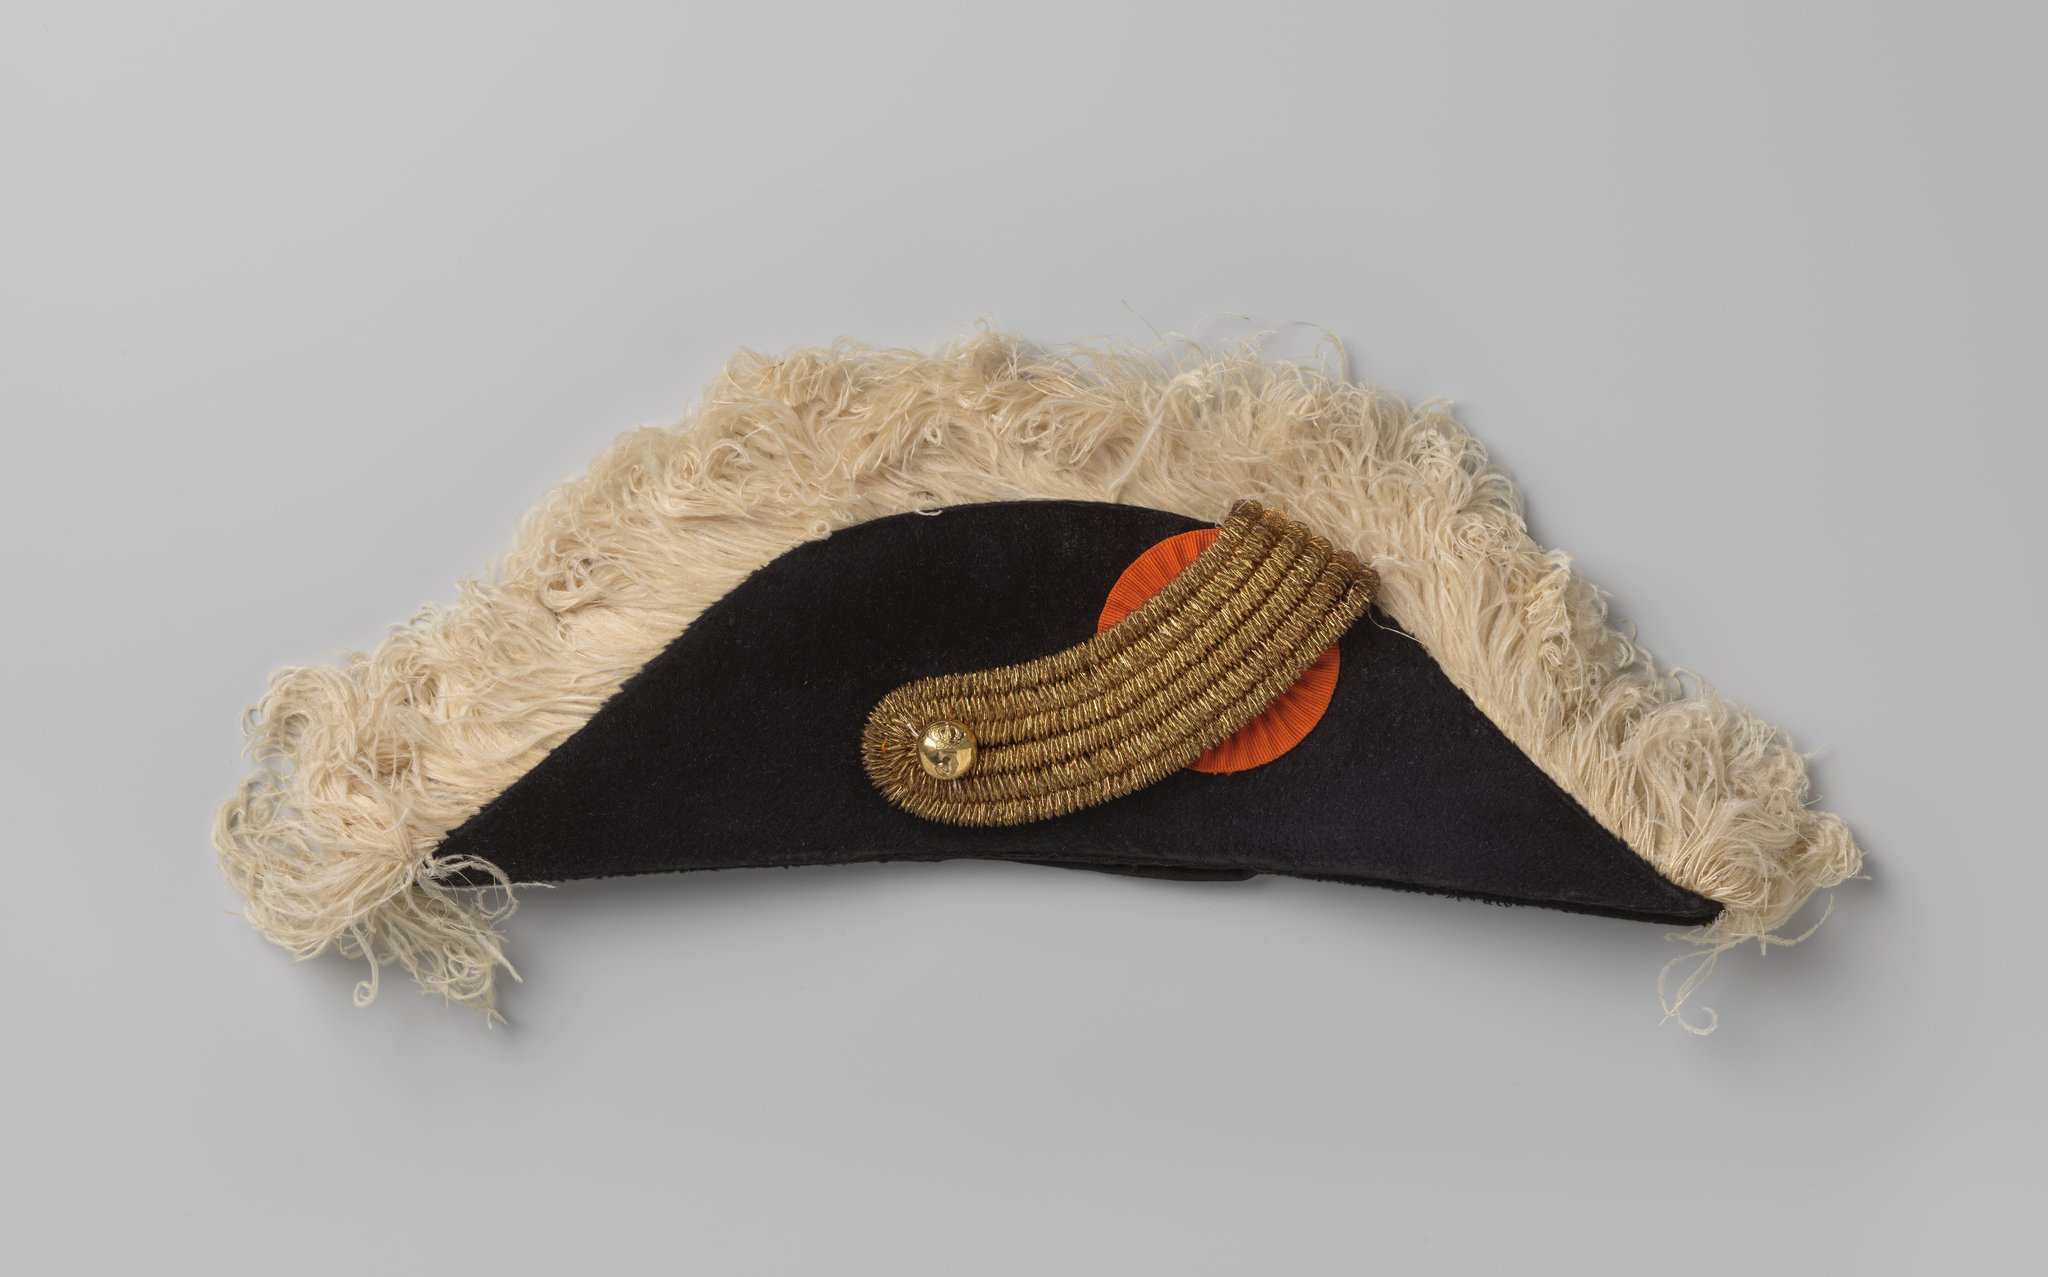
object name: bicorne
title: Steek van ambassadeur Allard Merens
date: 1945-1976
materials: metal, textile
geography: london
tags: the hague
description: Platte steek van donkerblauwe stof met witte struisvogelveren langs de rand. Rechts een oranje rozet met gouden band met knoop met gekroonde J, behorend bij de diplomatieke ambtskleding van ambassadeur Allard Merens.